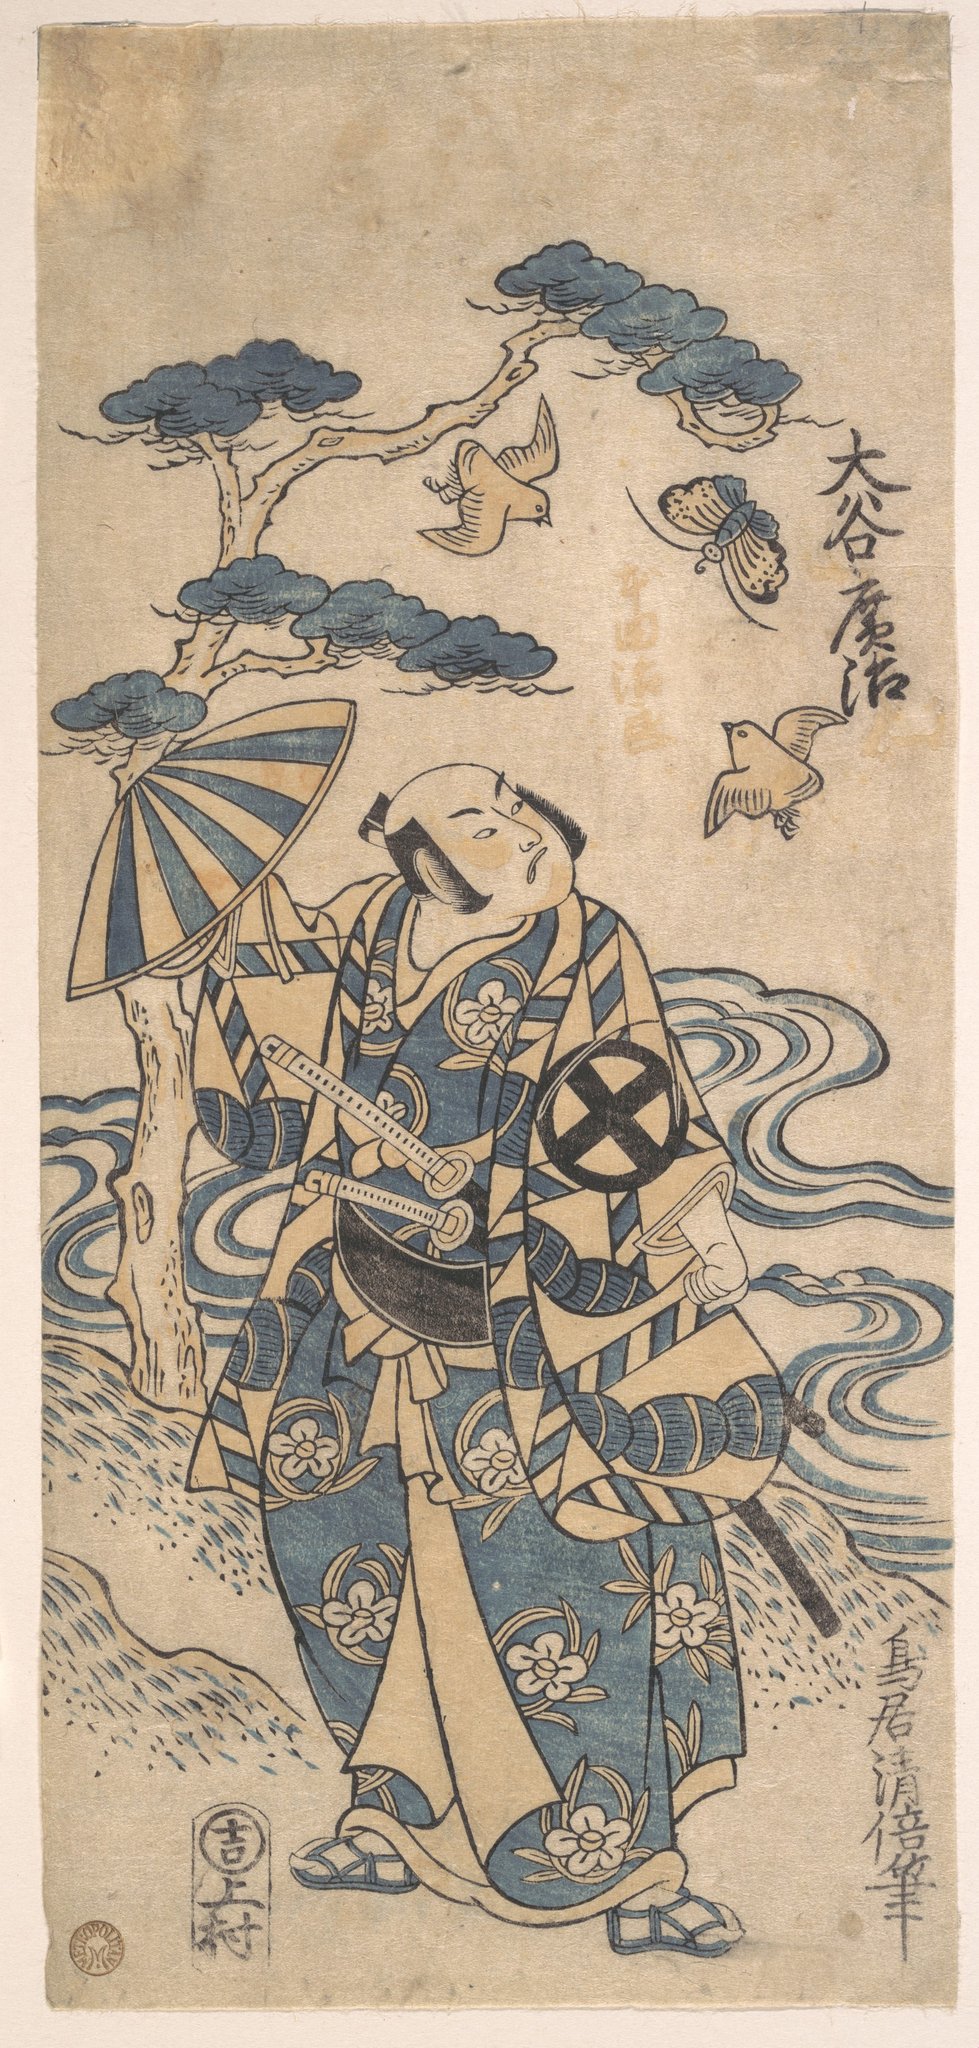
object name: print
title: The Actor Otani Hiroji as Honda Harunaga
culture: japanese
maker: torii kiyomasu i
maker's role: artist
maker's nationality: japanese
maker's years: 1696-1716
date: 1745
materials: ink, paper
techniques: woodblock print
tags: birds,men,butterflies,trees